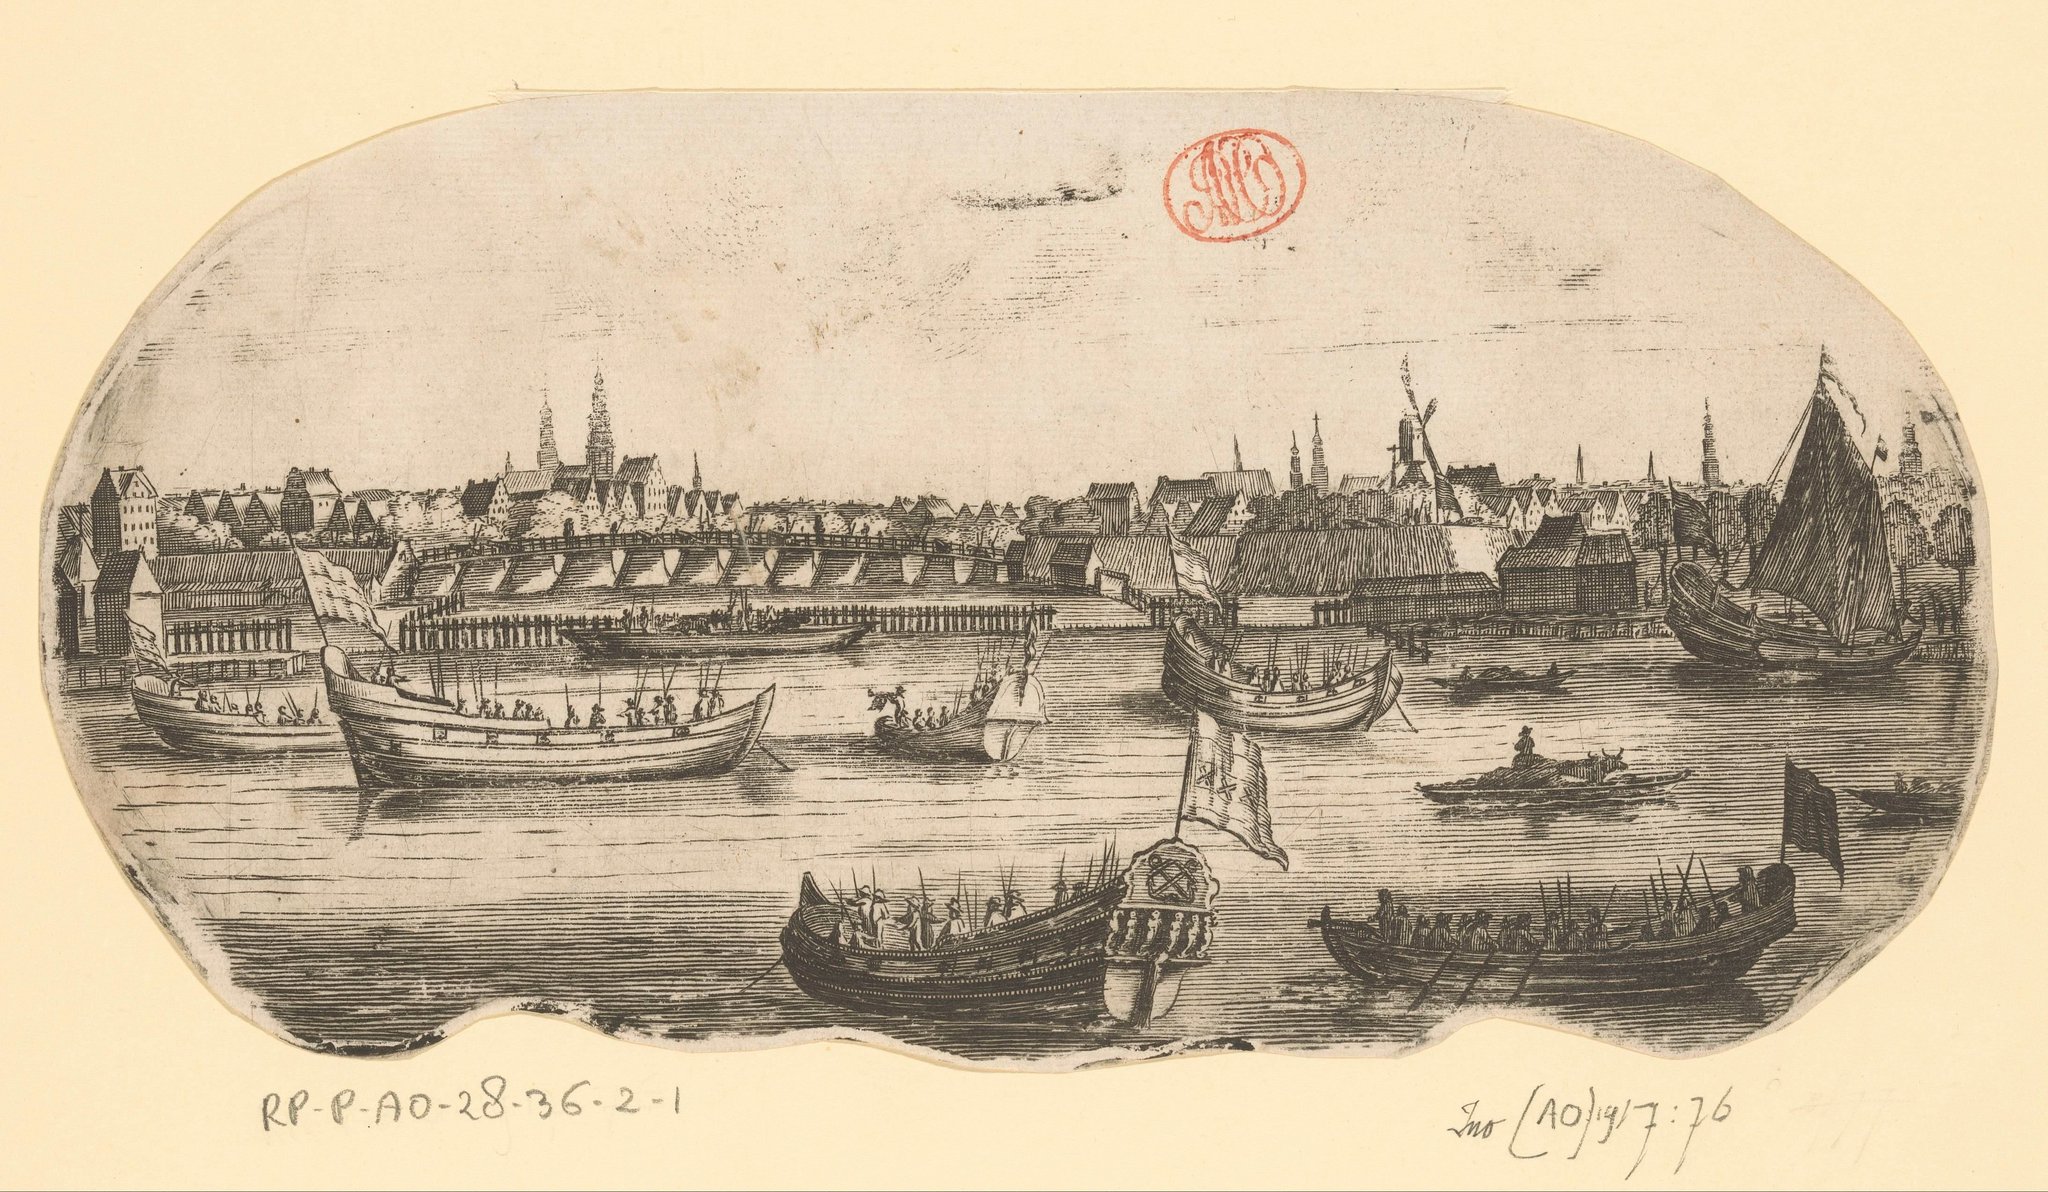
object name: print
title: Boten met schutters of soldaten in de Buiten-Amstel voor Amsterdam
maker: Anonymous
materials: paper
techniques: engraving, etching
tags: the soldier; the soldier's life, ships (in general) - cc - more than one ship, prospect of city, town panorama, silhouette of city, amsterdam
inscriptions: collector's mark: Lugt 195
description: Boten met schutters of soldaten in de Buiten-Amstel voor Amsterdam, hoogstwaarschijnlijk rond de Aanslag op Amsterdam van 1650. Op de achtergrond de Blauwbrug en de toren van de Zuiderkerk.